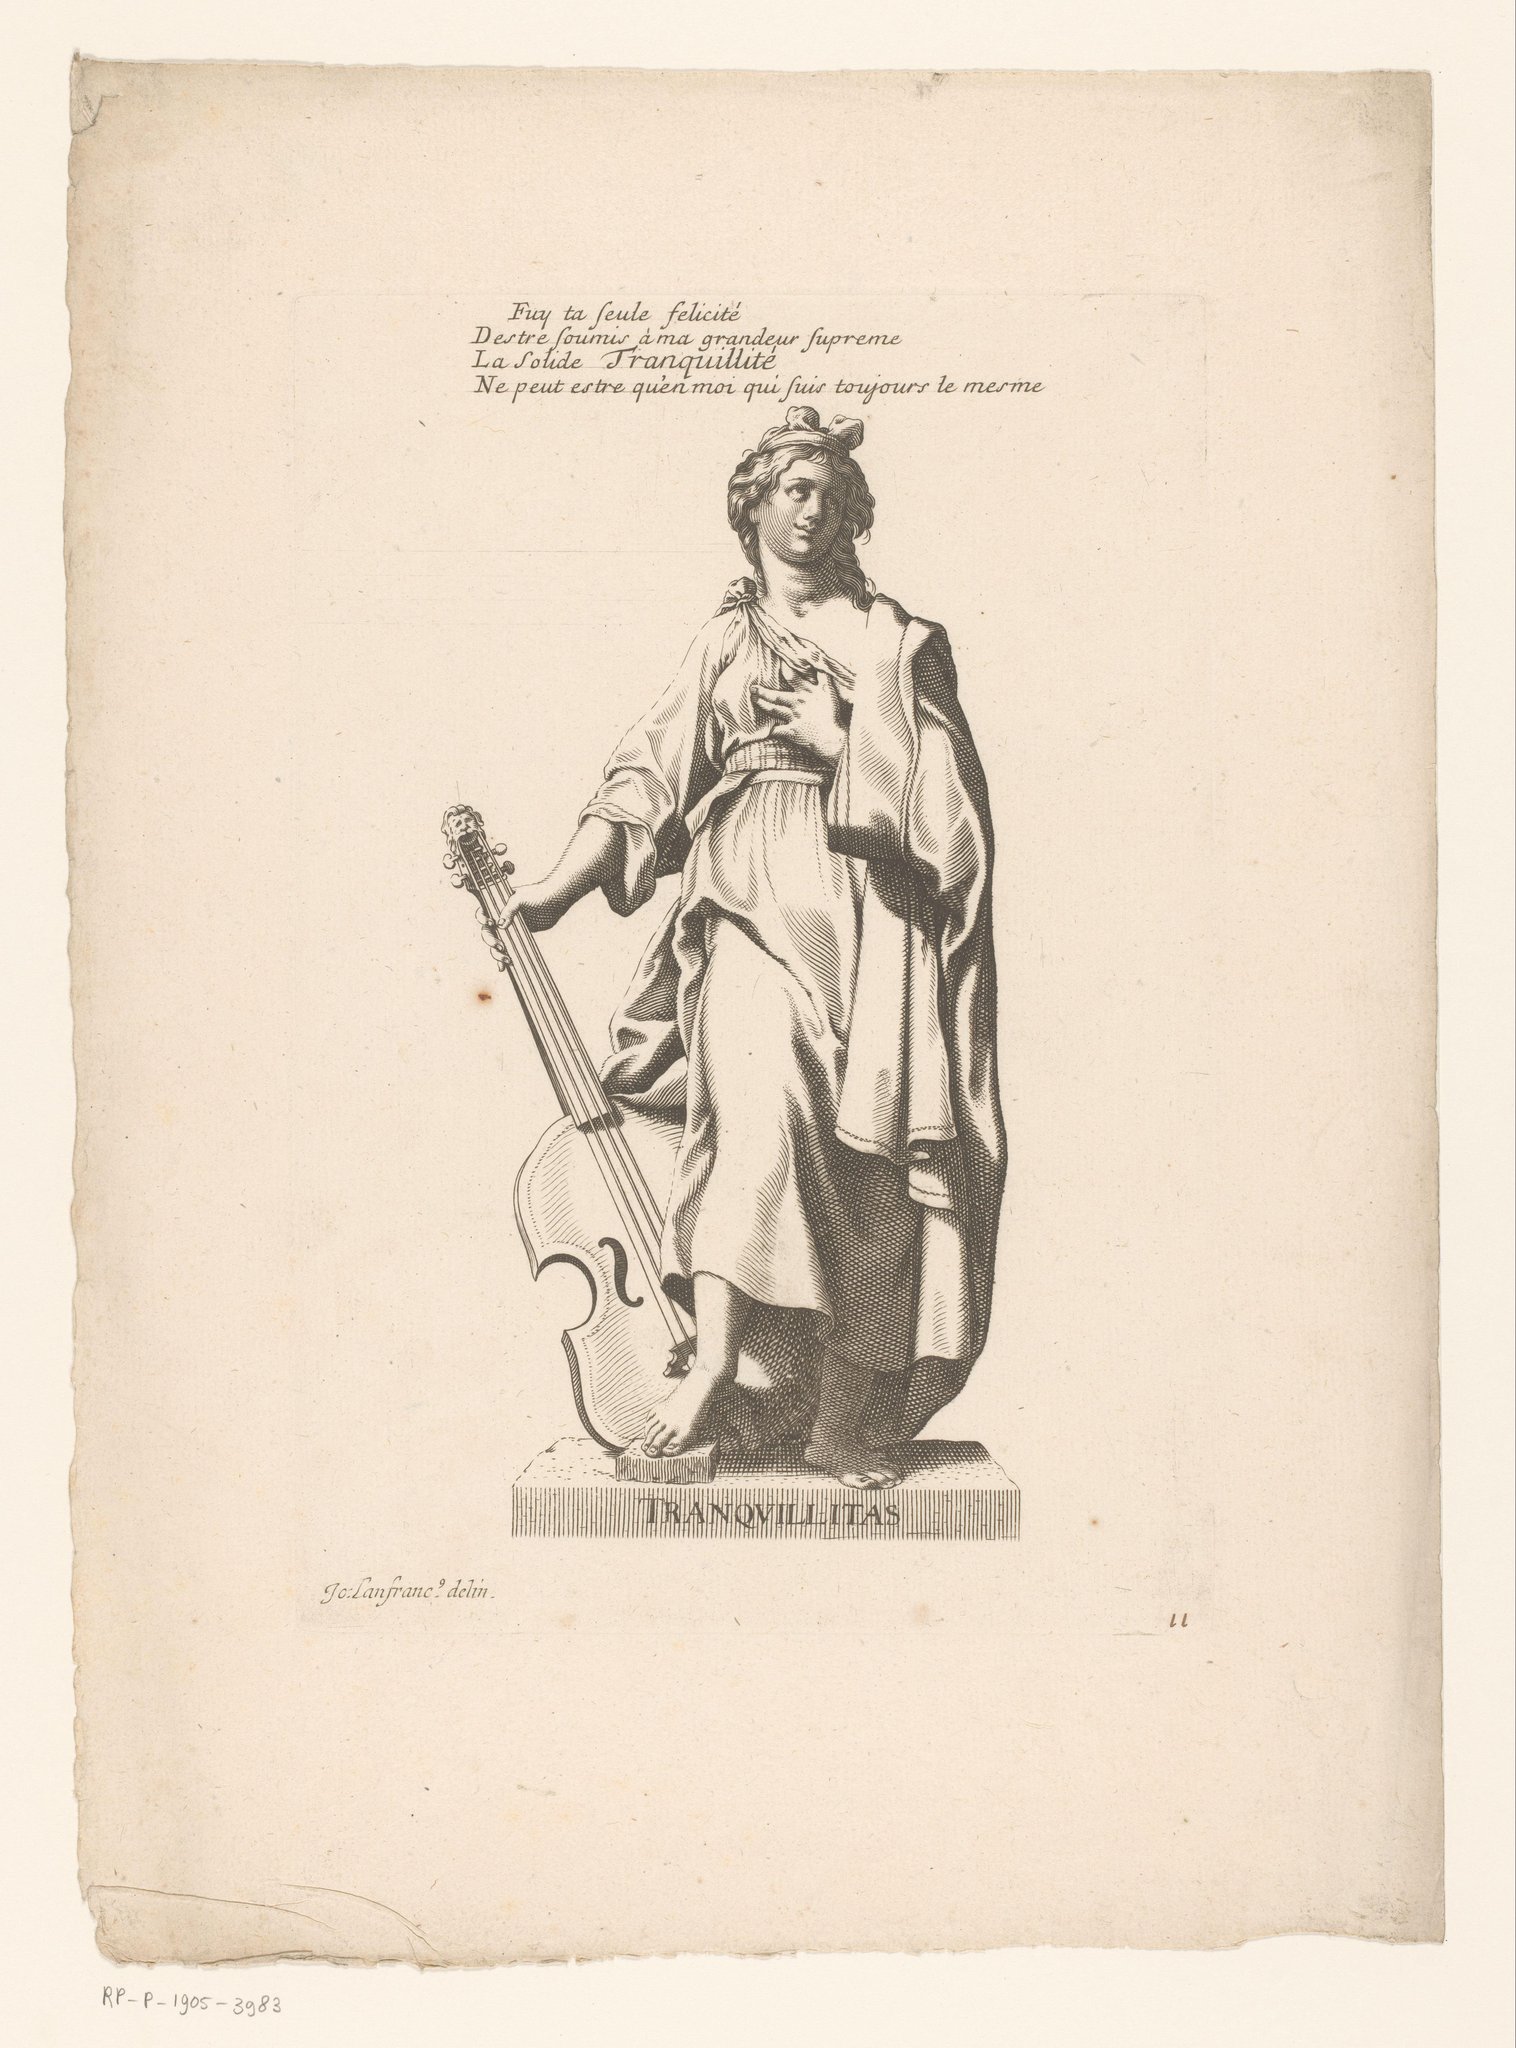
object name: print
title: Tranquillitas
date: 1645-1709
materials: paper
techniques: engraving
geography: france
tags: confidence, security, tranquillity; 'confidenza', 'sicurezza e tranquillità', 'sicurtà', 'sicurtà o sicurezza', 'tranquillità' (ripa)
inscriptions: collector's mark: Lugt 2228, number: ‘11’, number: ‘59’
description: Maakt deel uit van een zestiendelige serie met personificaties van de deugden naar ontwerp van Giovanni Lanfranco en uitgegeven door Jean II Leblond.